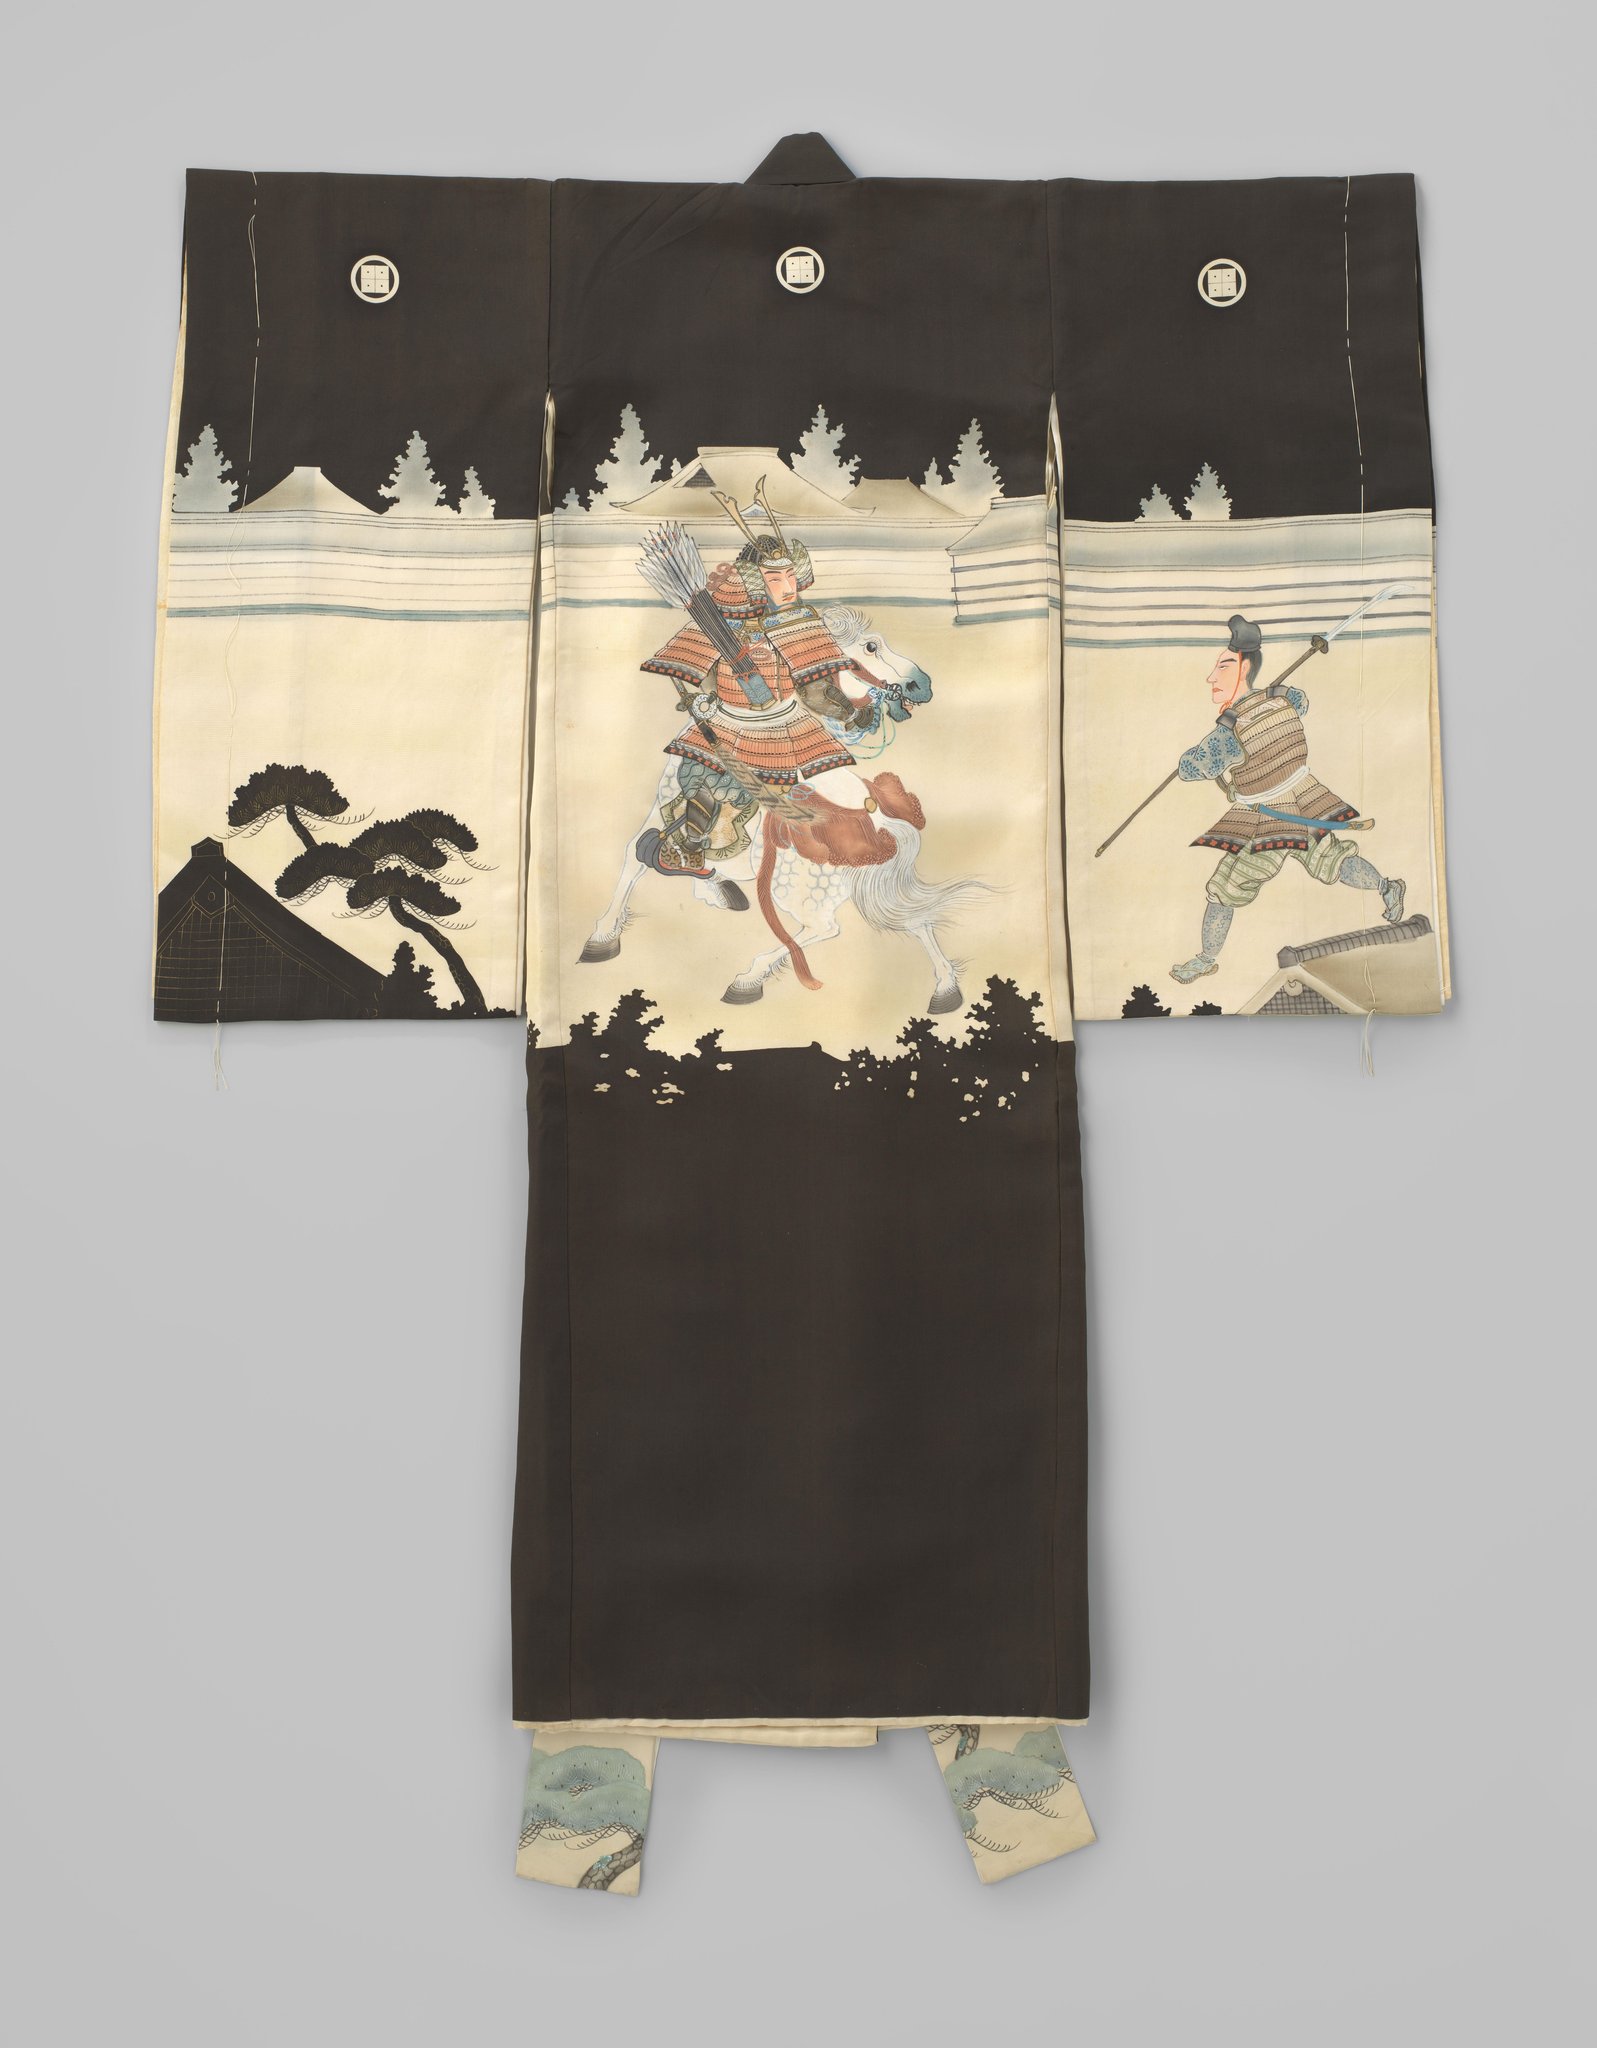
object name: kimono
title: Jongens miyamairi kimono met Yoshitsune te paard en Benkei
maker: Anonymous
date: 1920-1940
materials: silk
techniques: painting, weave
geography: japan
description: Kimonos: Mirrors of a Man’s Life. The kimonos on view here afford a glimpse into the lives of Japanese men from around the 1910s to the 1950s, from childhood to adulthood. This was a period of great change for Japan, marked by increasing industrialization and political conflicts culminating in the Second World War. Life modernized, technology advanced, and people took up new hobbies. Traditionally, men’s outer clothing tended to be reserved and a solid colour. Clothes could nevertheless also be a medium for highly unusual depictions which, however, were not visible to everyone. While motifs adorned the exterior of children’s garments, they were hidden from view in those worn by adult men. The decoration was found on the inside: on a long under garment, or the lining of a jacket (haori). This concealed imagery divulges the lives of the owners at the beginning of the 20th century. Childhood. A kimono marked events and stages in a man’s life. The kimonos on the top row (except the two everyday ones at either end) were worn by boys during the religious ceremony of miyamairi, namely an infant’s first visit to a Shinto shrine. This event followed a prescribed ritual and was an important and formative moment in the life of a Japanese man. Clothing for boys enveloped them in images that were to become part of their identity. The depictions included motifs that were considered gender and age appropriate: toys, manly hobbies, stories of heroic battles, technology, and so forth. Broader themes such as military conflicts and nationalism also filtered into children’s daily lives at an early stage. The textile designs of some kimonos combined traditional playthings with toy guns and tanks. Adulthood. What does a kimono tell about its owner and his life? Some men chose subjects from classical culture, such as No or Kabuki theatre, while others preferred themes from contemporary life, such as gramophone records or the new popular sport of baseball. Thus, these garments were a canvas for personal choices, but also for political propaganda and nationalistic messages. Some representations are eccentric or even erotic. Others are more general and linked to political events. All aspects of a man’s inner life are touched on. Portraits of beautiful women and playful dogs contrast with images of war, celebrating victories in China. As these representations were under the outer garments, they remained hidden from the outside world and were thus seen only by the kimono’s owner and his intimates.